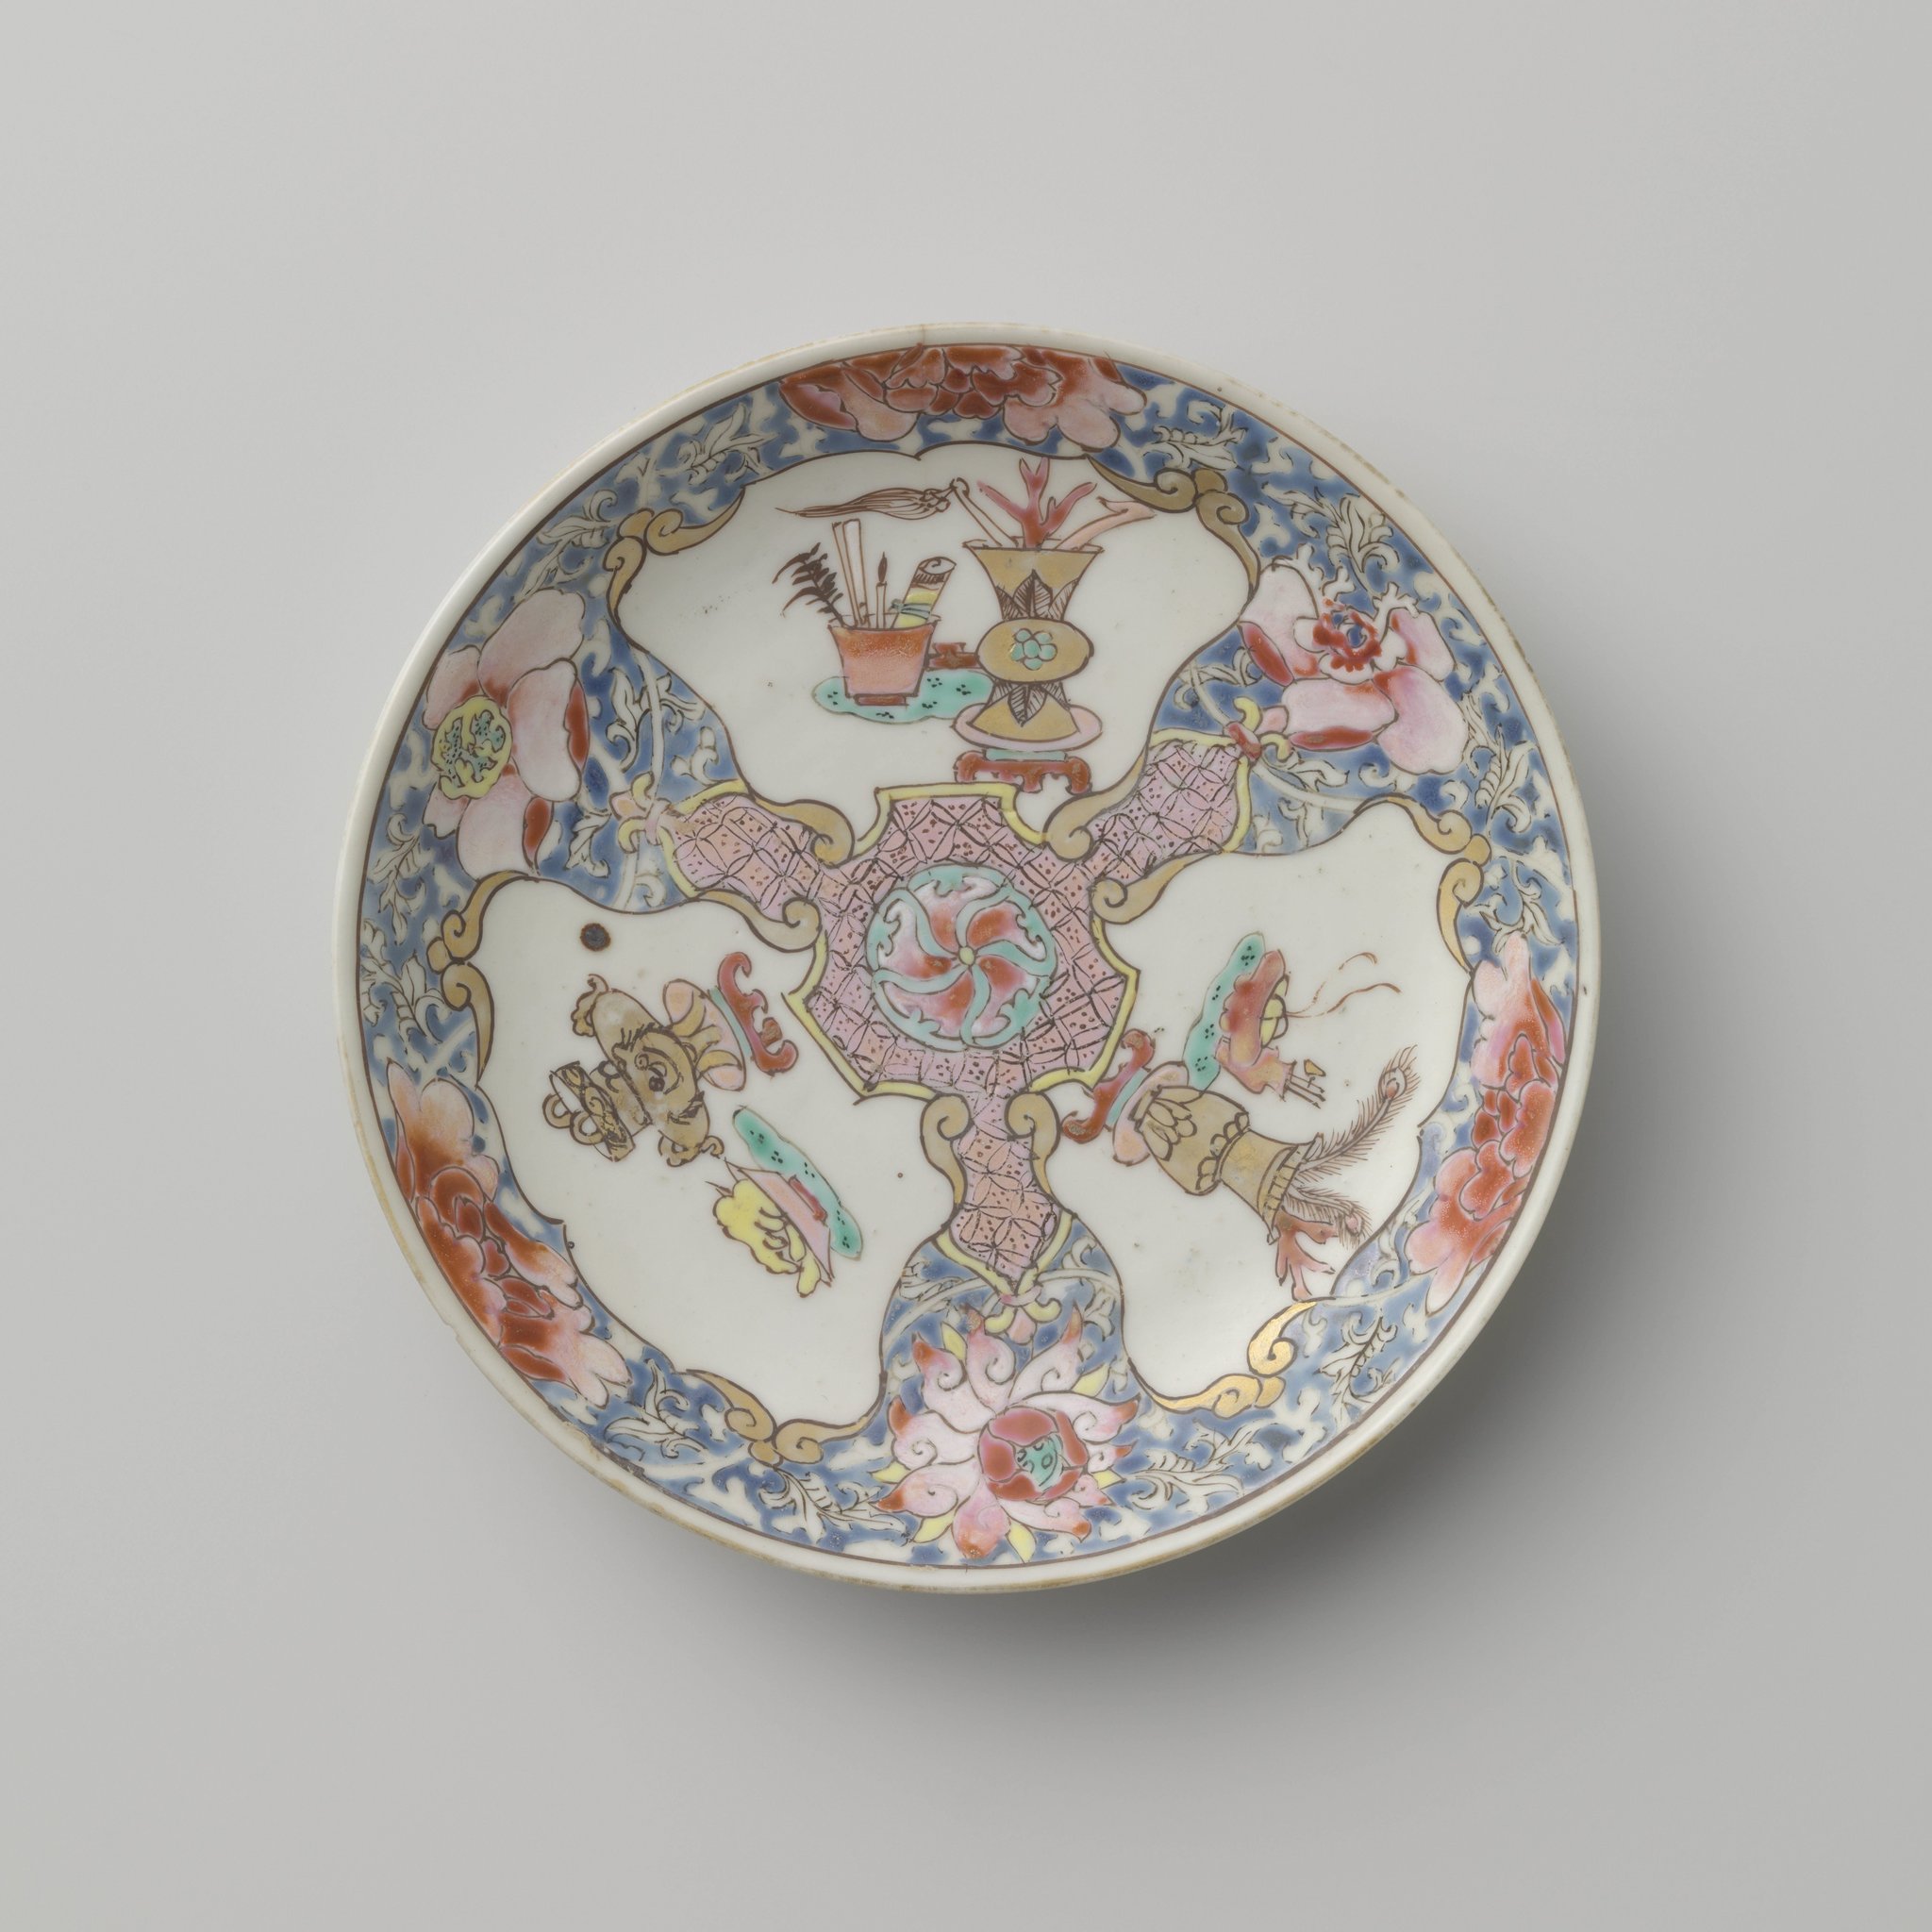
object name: kop en schotel, kop en schotel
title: Saucer with antiquities in panels on a ground of floral scrolls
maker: Anonymous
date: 1800-1899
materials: glaze, gold, paint, porcelain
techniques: firing, gilding, turning, vitrification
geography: china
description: Schotel van porselein, beschilderd op het glazuur in blauw, rood, roze, turquoise, geel, roze en goud. Op het plat van de schotel een medaillon in een driehoek met servetwerk, daaromheen drie cartouches met antiquiteiten (fruitschaal met vingercitroen, vazen met pauwenveren en koraal, wierookbrander, scepter, objecten van een geleerde etc.) tegen een achtergrond van bloemranken. Een barst in de rand van de schotel. Famille rose.